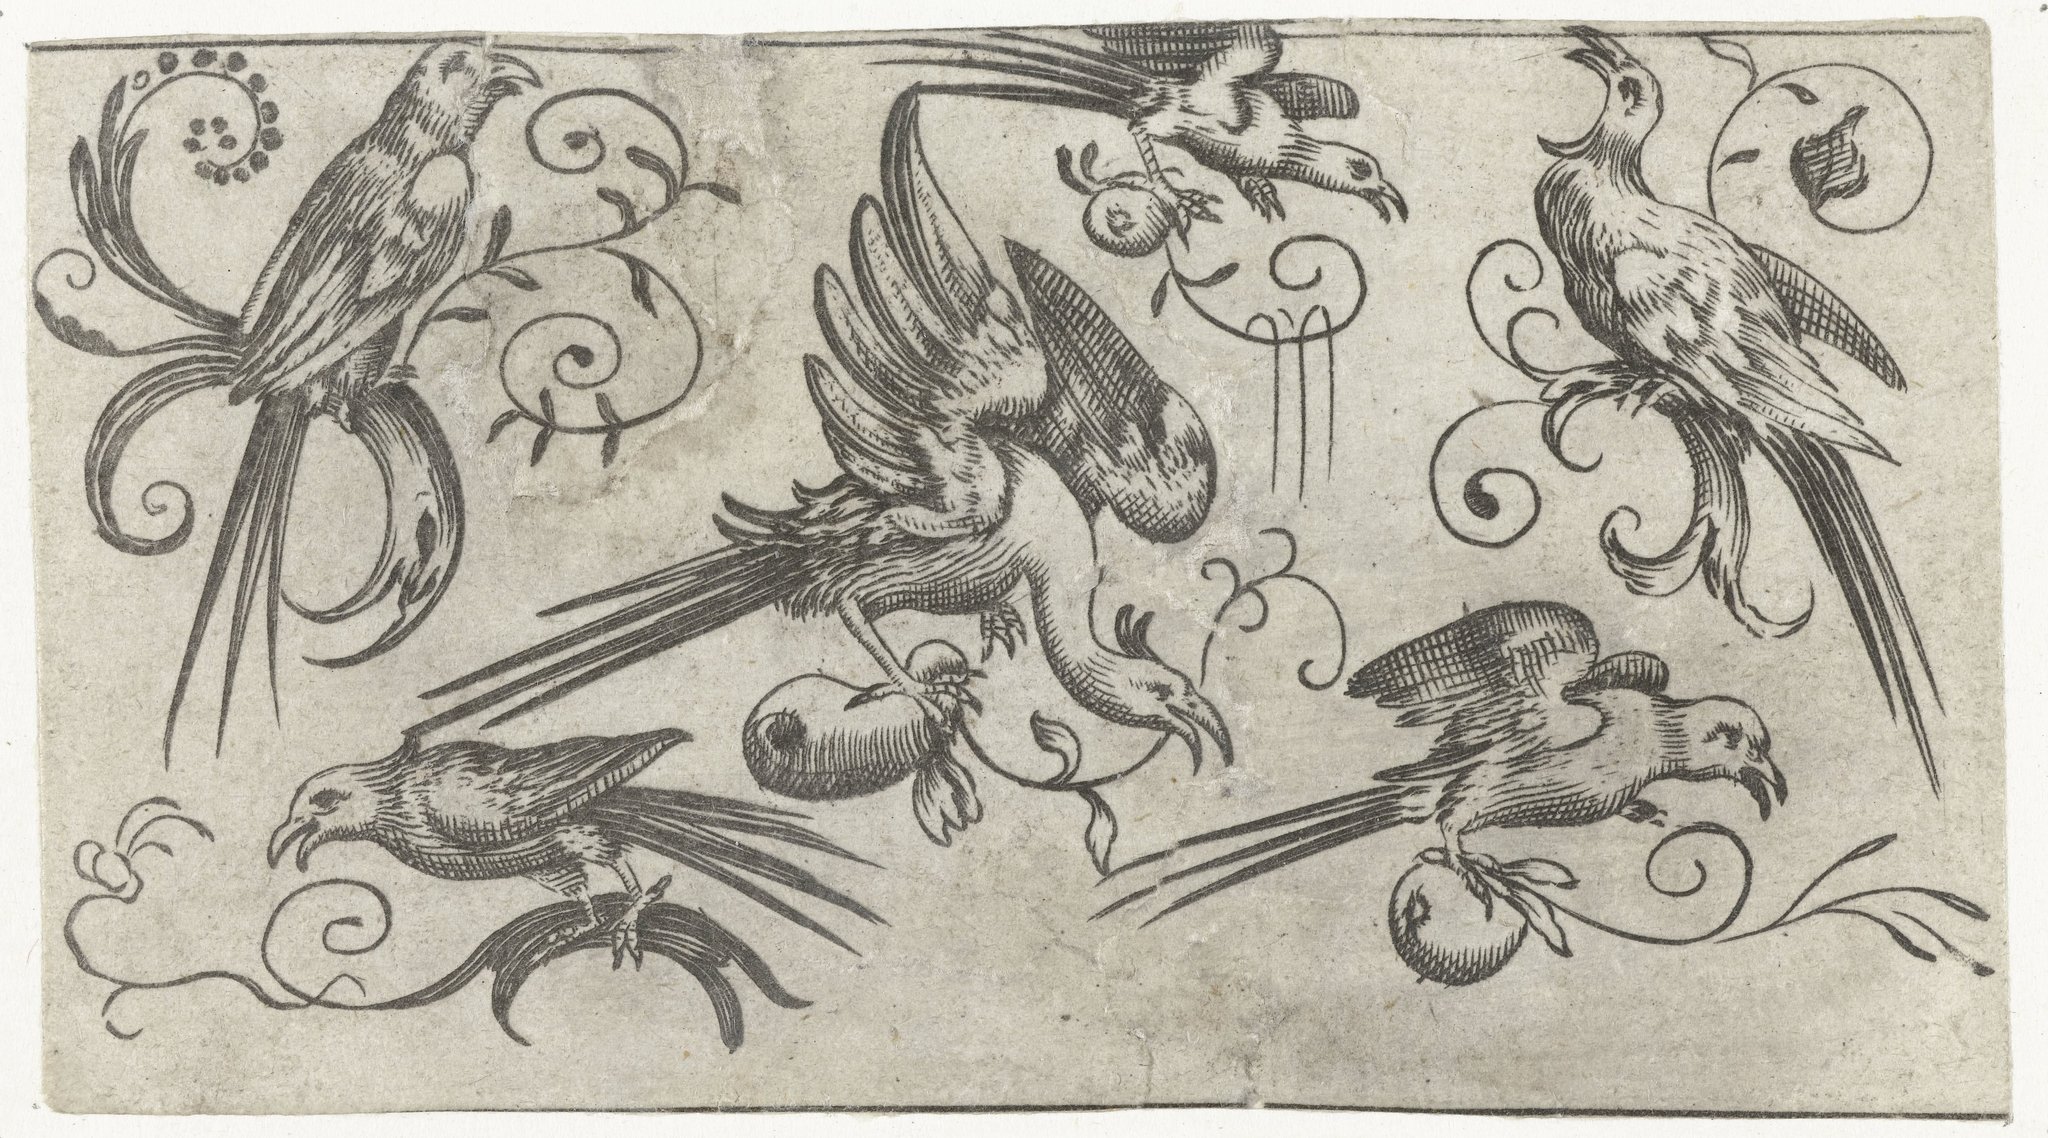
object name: print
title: Zes vogels op takken met ranken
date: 1600-1699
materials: paper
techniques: etching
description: Tegenzijdige kopie naar prent met objectnummer RP-P-1965-902.